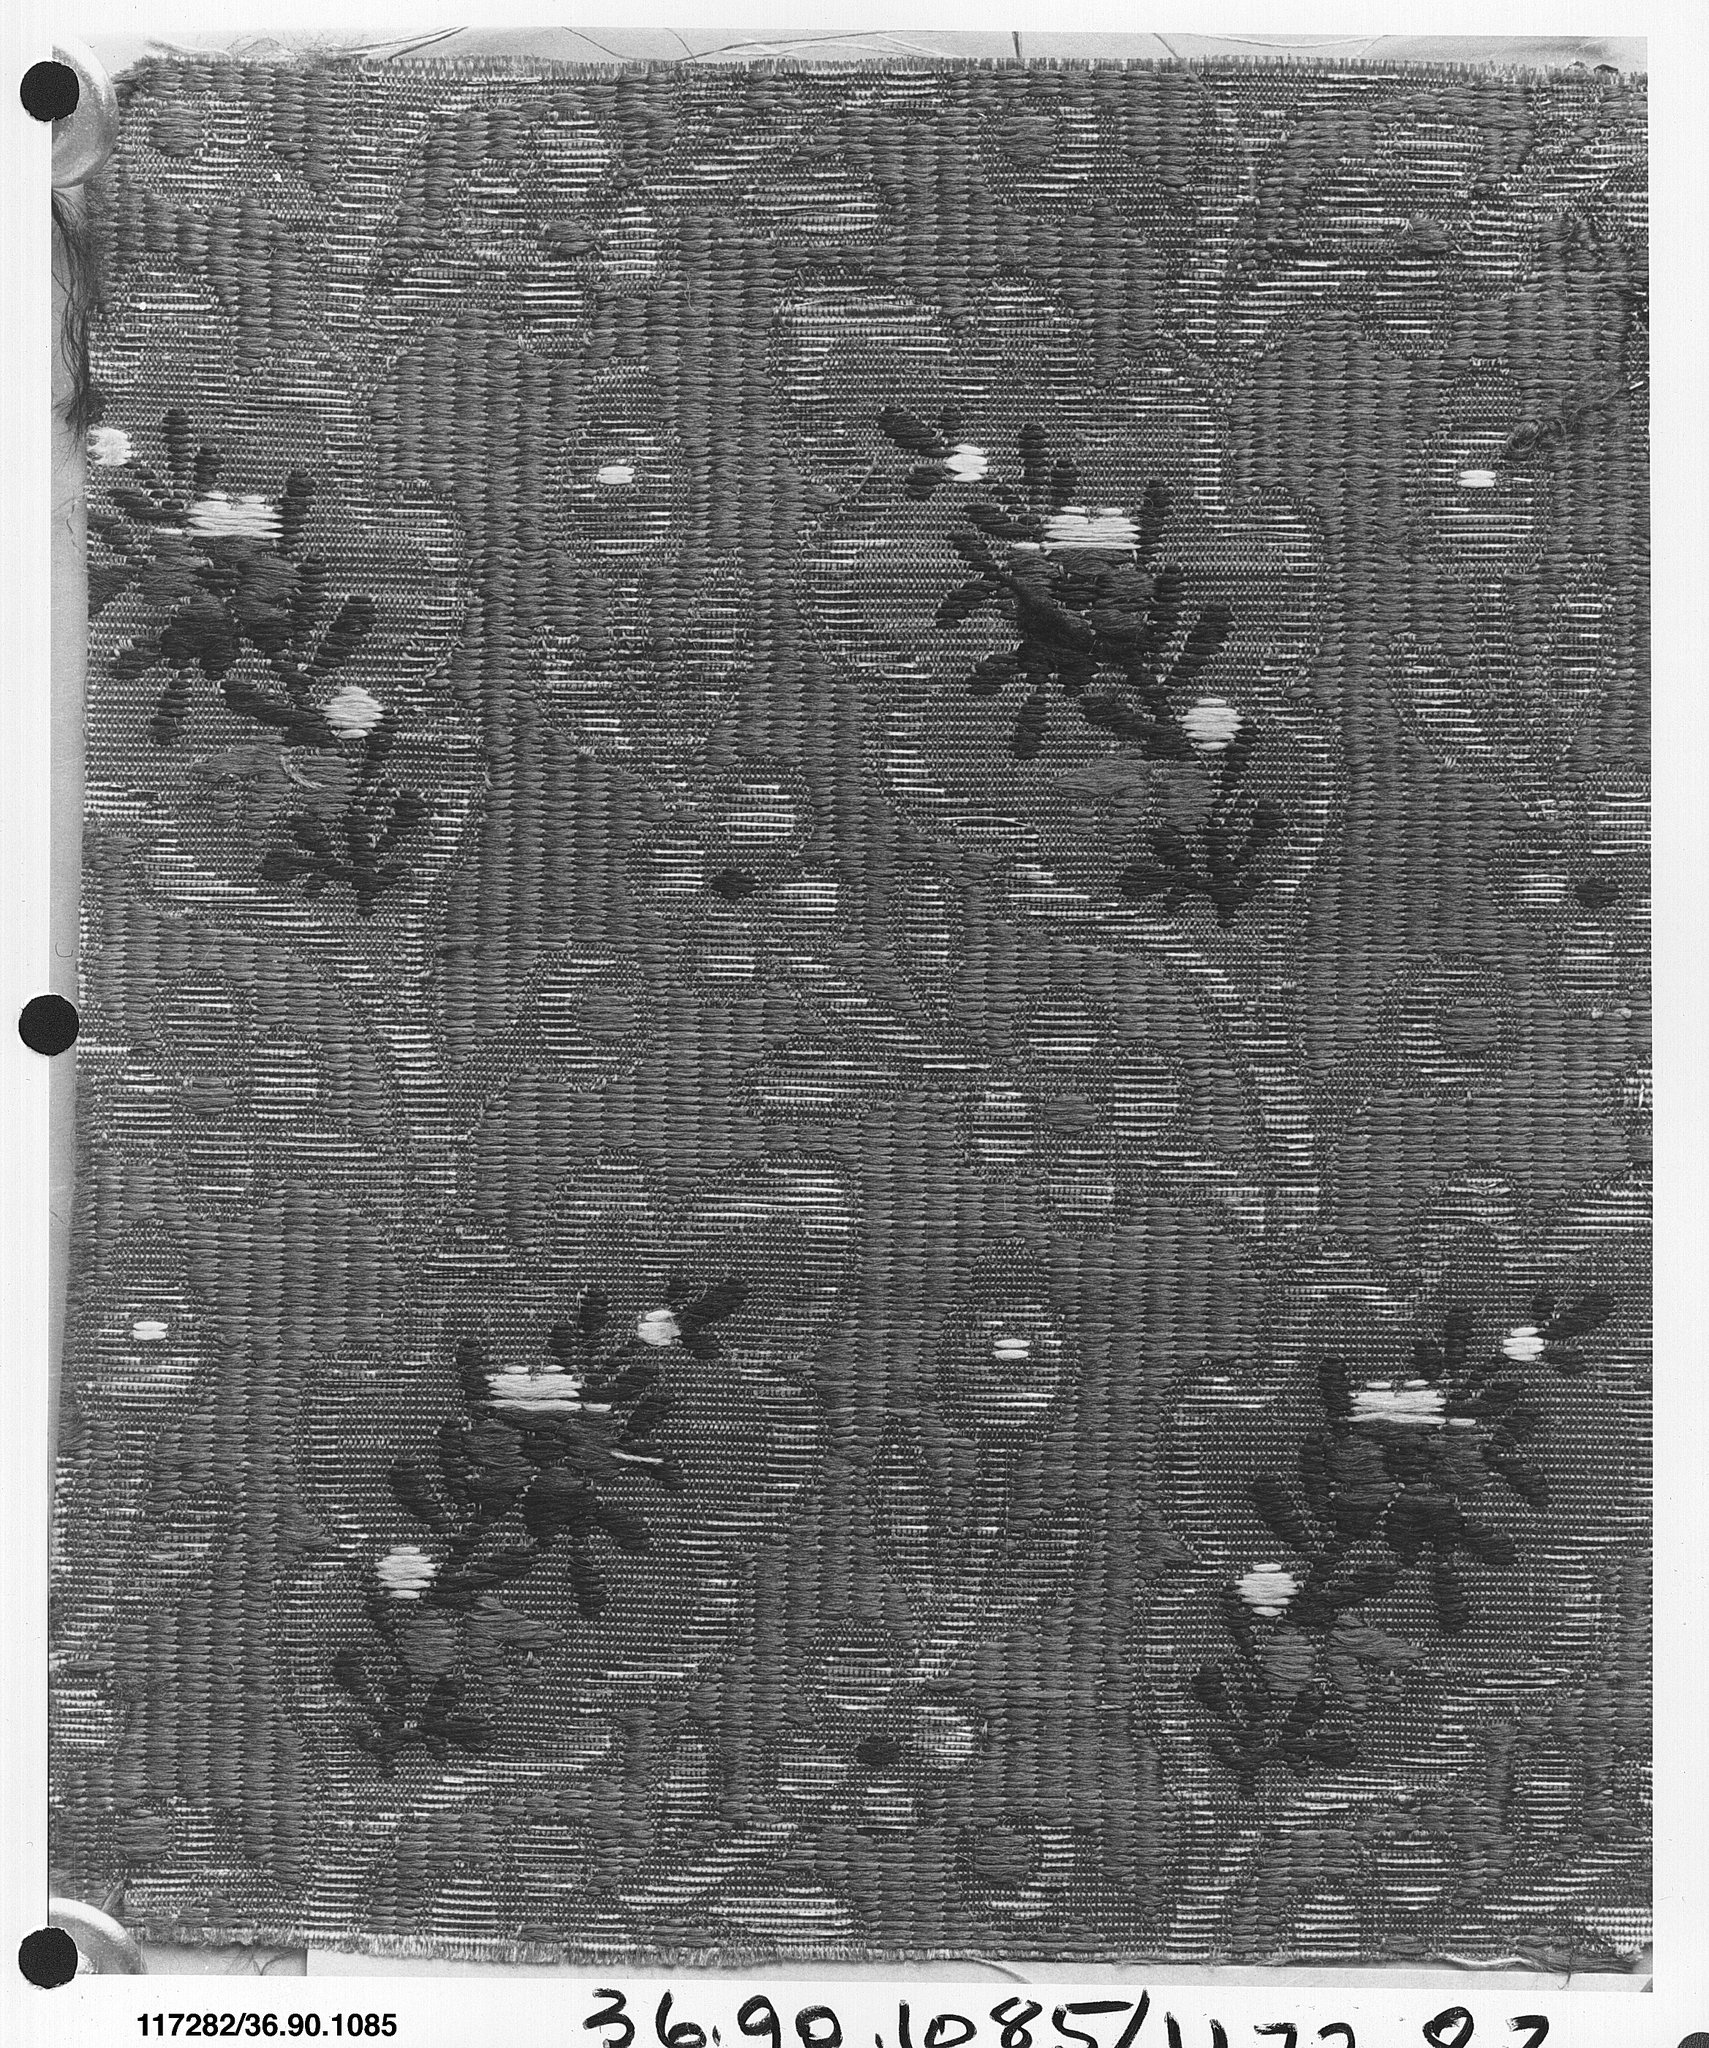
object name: piece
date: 1701-1900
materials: metal thread, silk